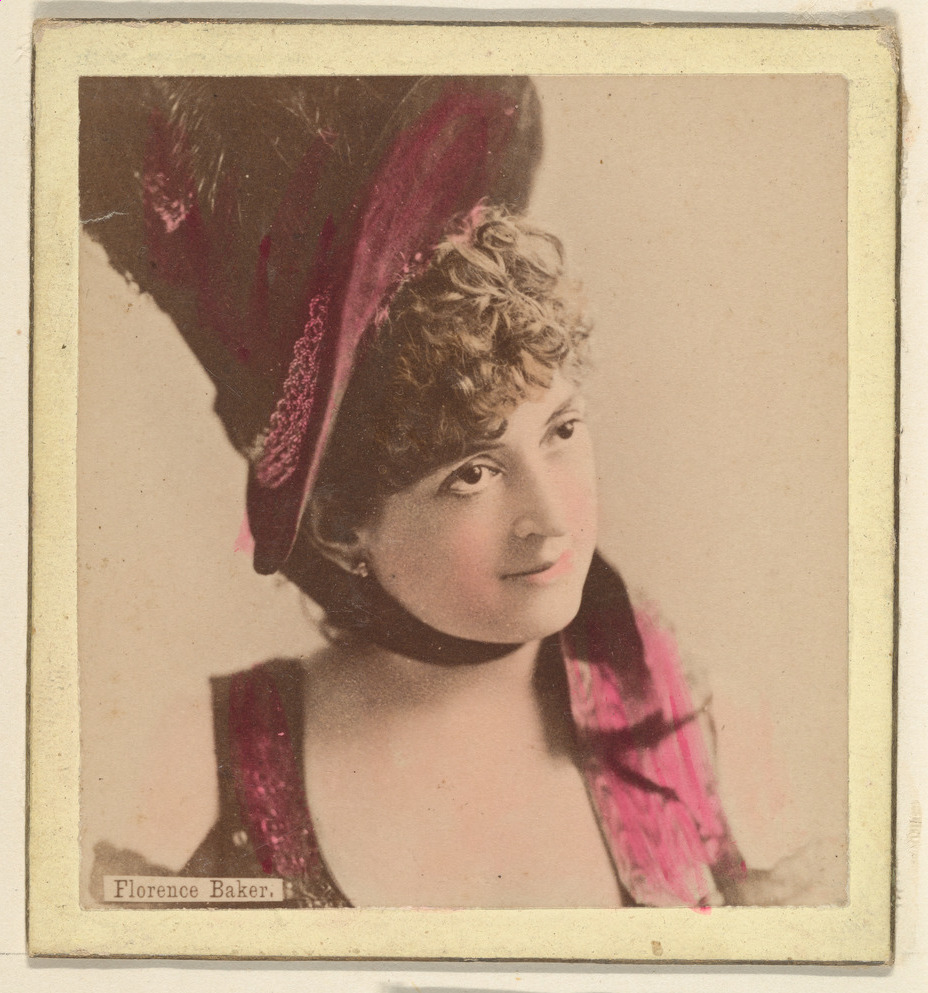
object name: photograph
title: Florence Baker, from the Actresses series (N246), Type 2, issued by Kinney Brothers to promote Sporting Extra Cigarettes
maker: kinney brothers tobacco company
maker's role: publisher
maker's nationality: american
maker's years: 1869-2011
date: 1890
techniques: albumen silver print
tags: portraits,women,actresses